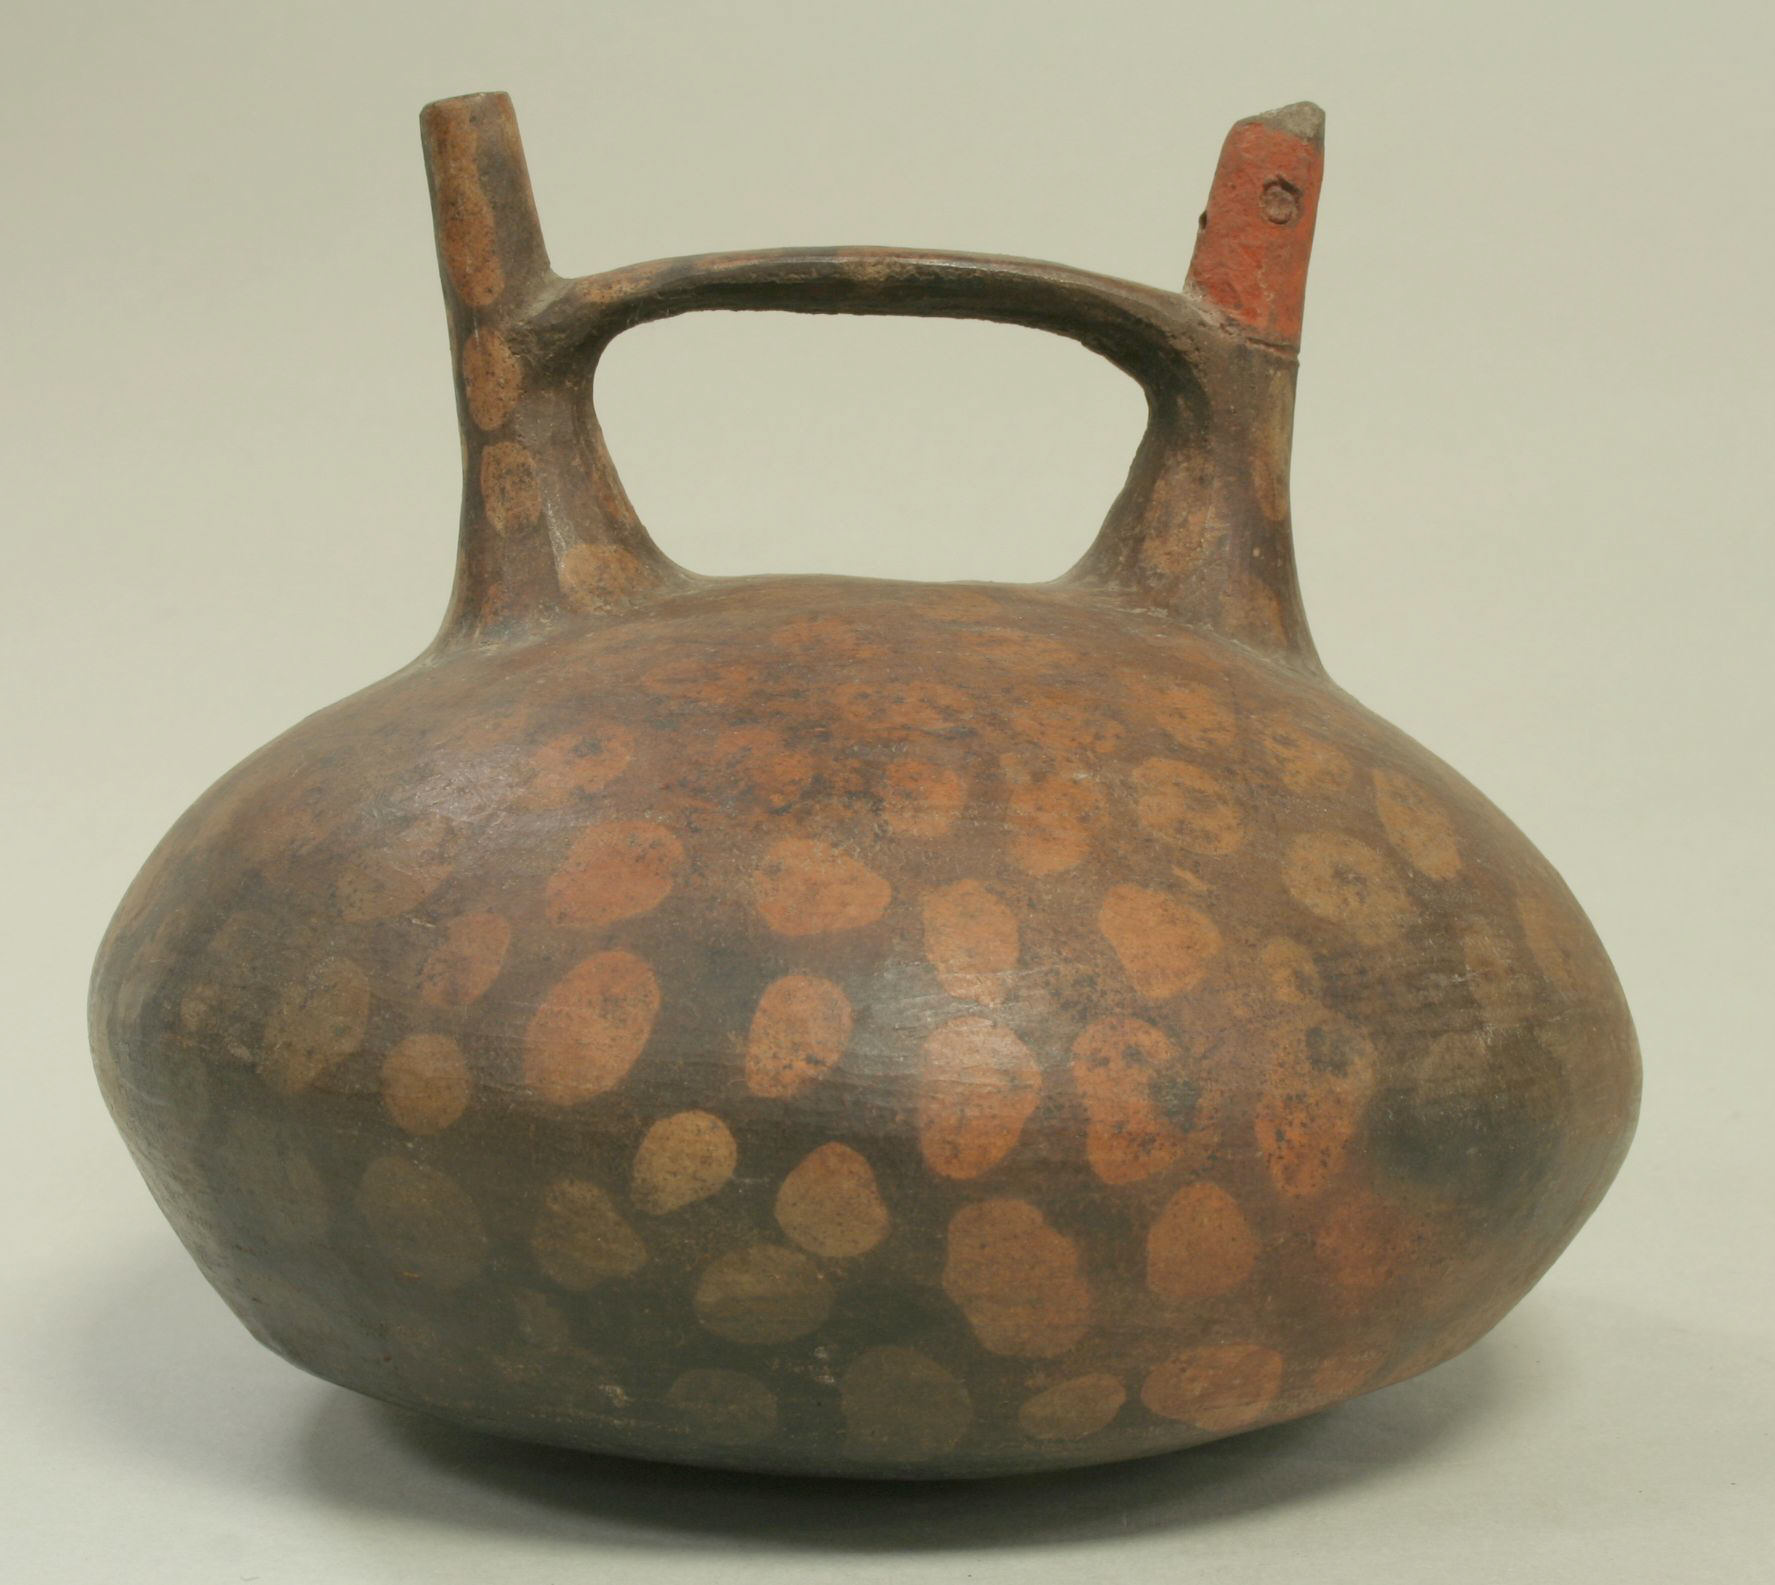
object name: bottle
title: Double Spout and Bridge Bottle with Bird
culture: paracas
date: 500-101 BCE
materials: ceramic, pigment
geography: peru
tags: birds